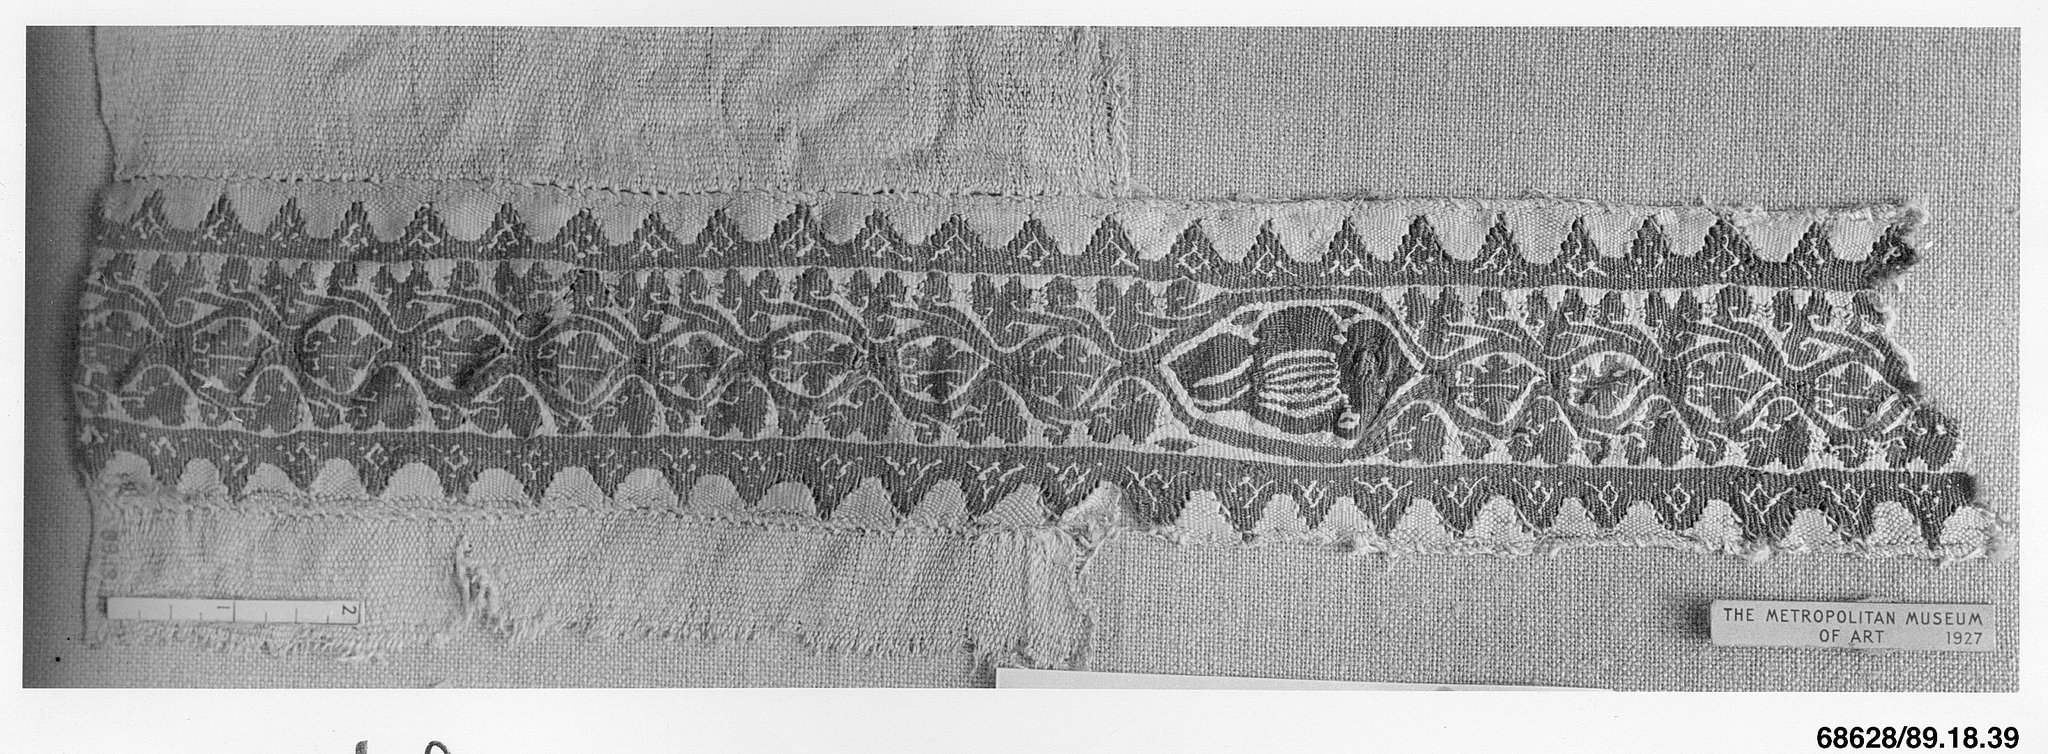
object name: textile fragment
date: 201-400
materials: linen, wool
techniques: weave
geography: egypt